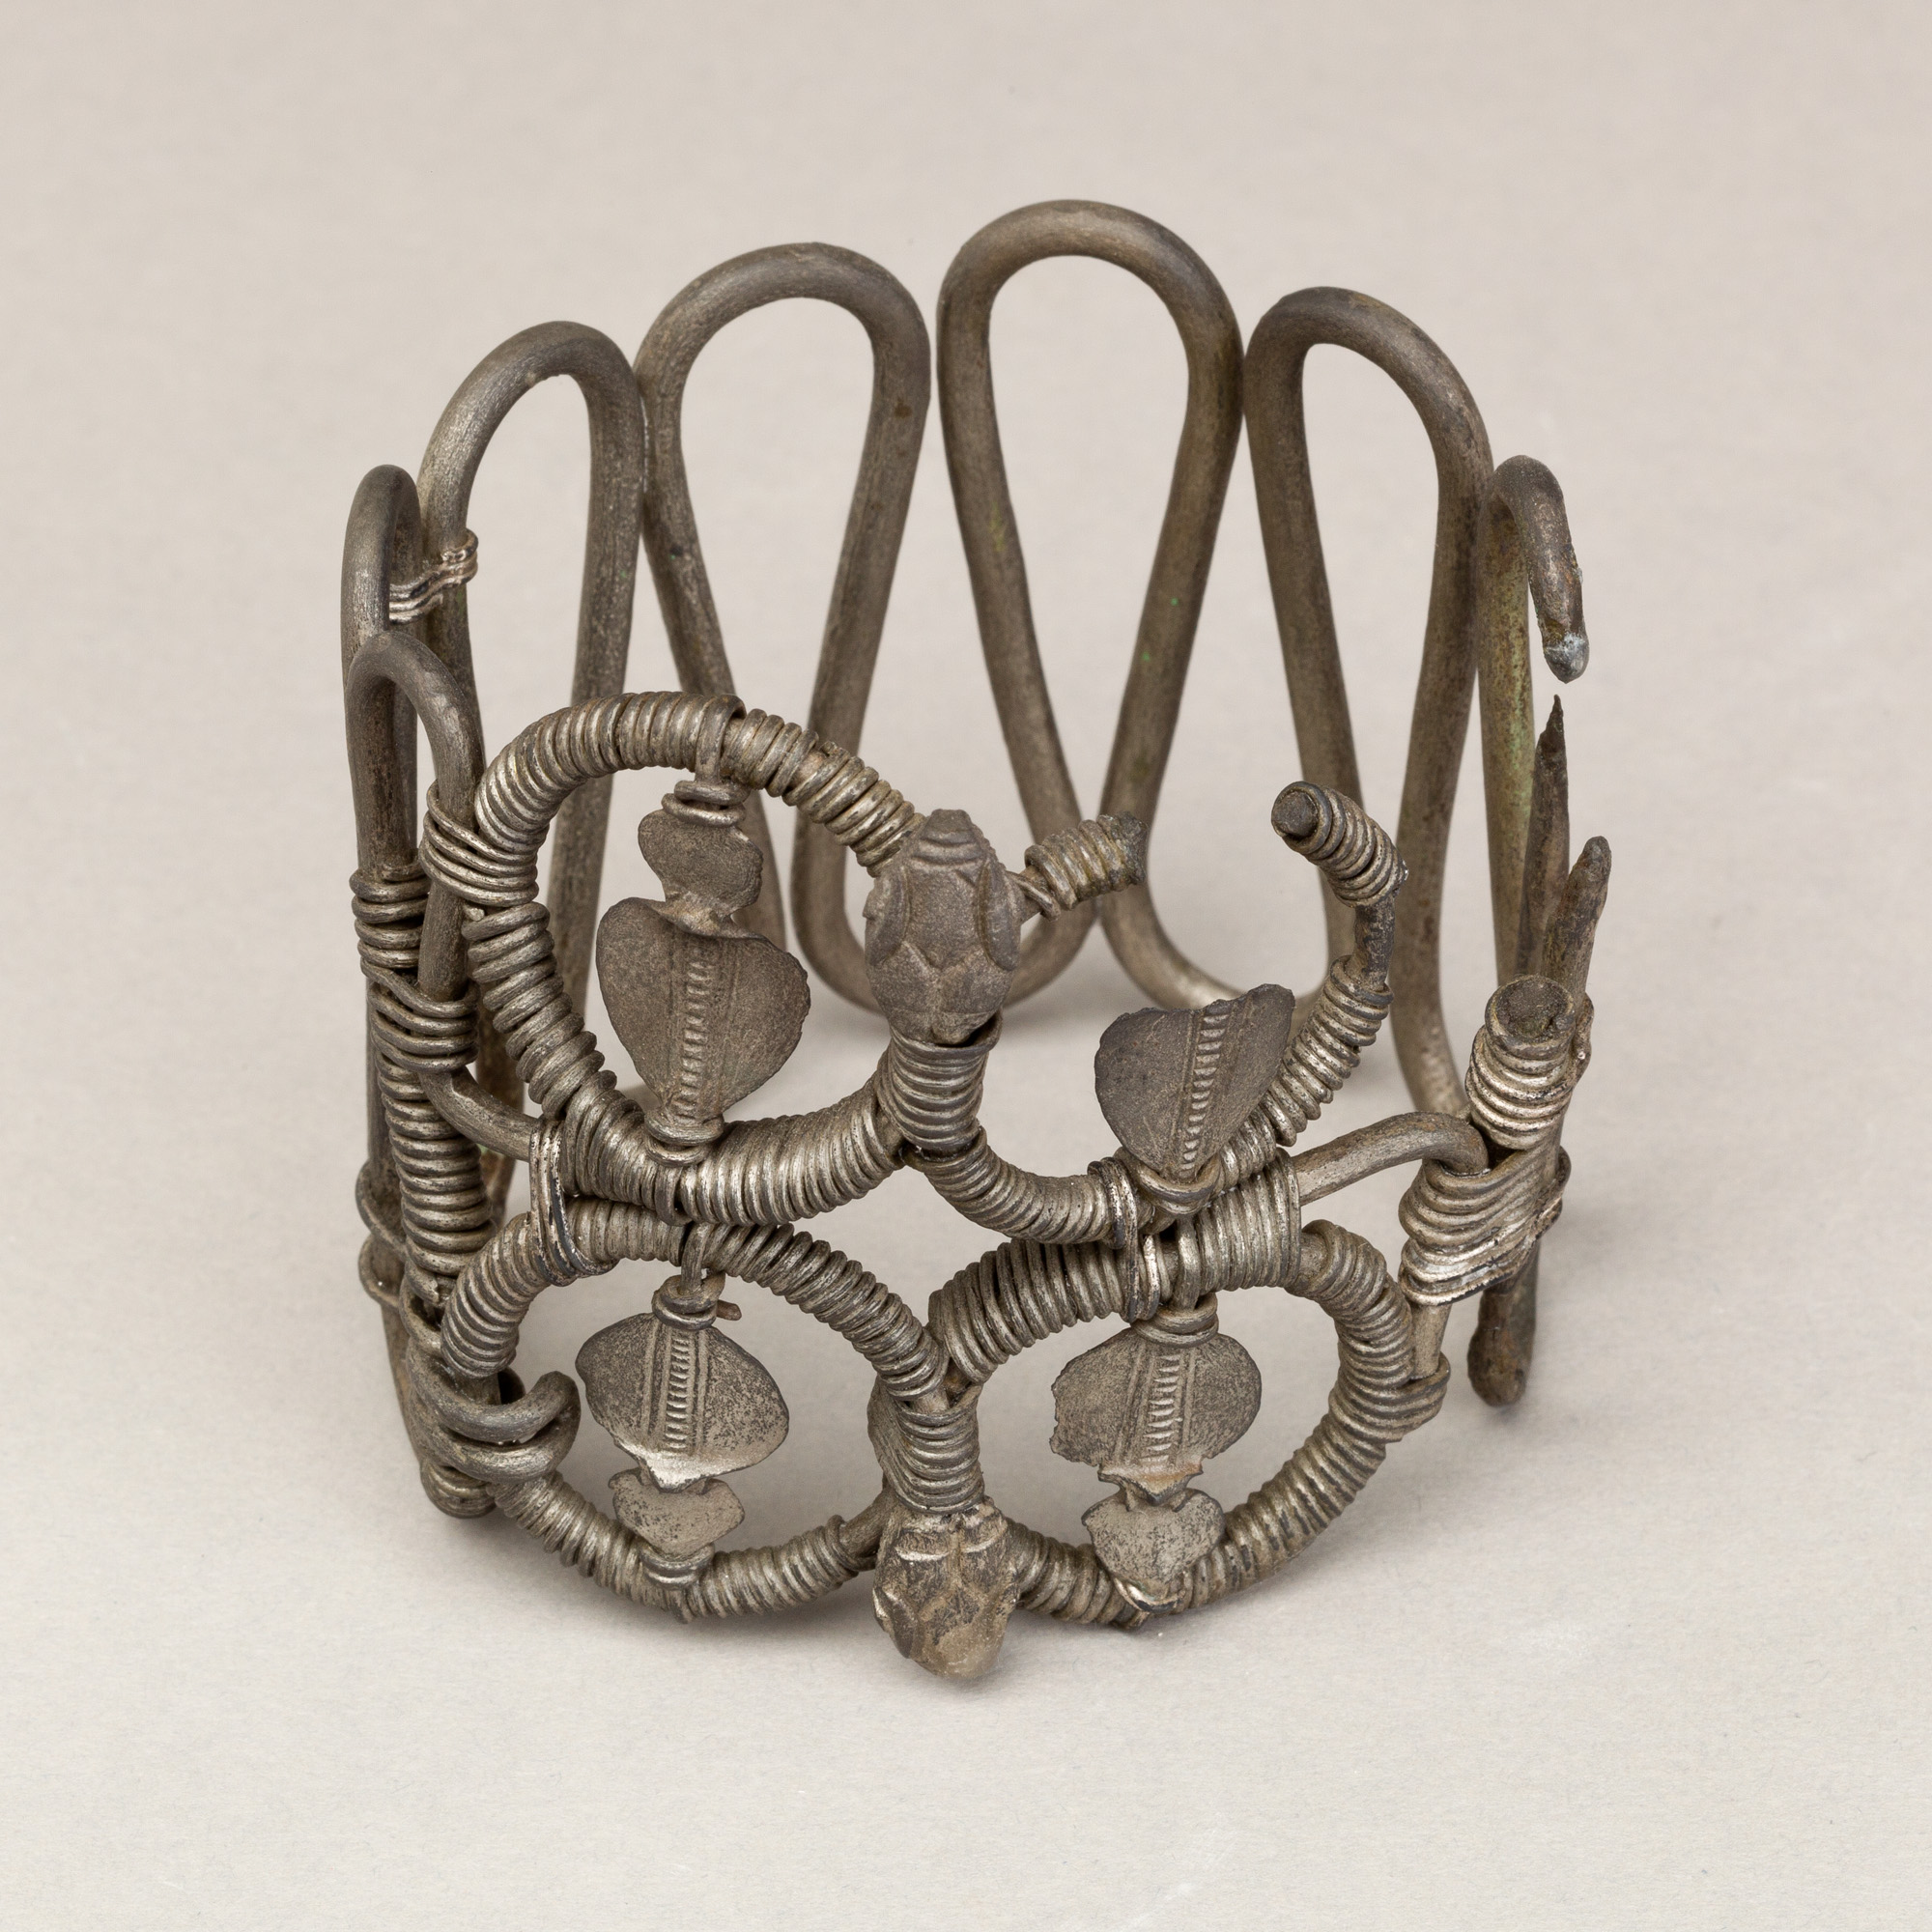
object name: bracelet or armlet, uraei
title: Bracelet or armlet with uraei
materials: silver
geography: egypt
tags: serpents